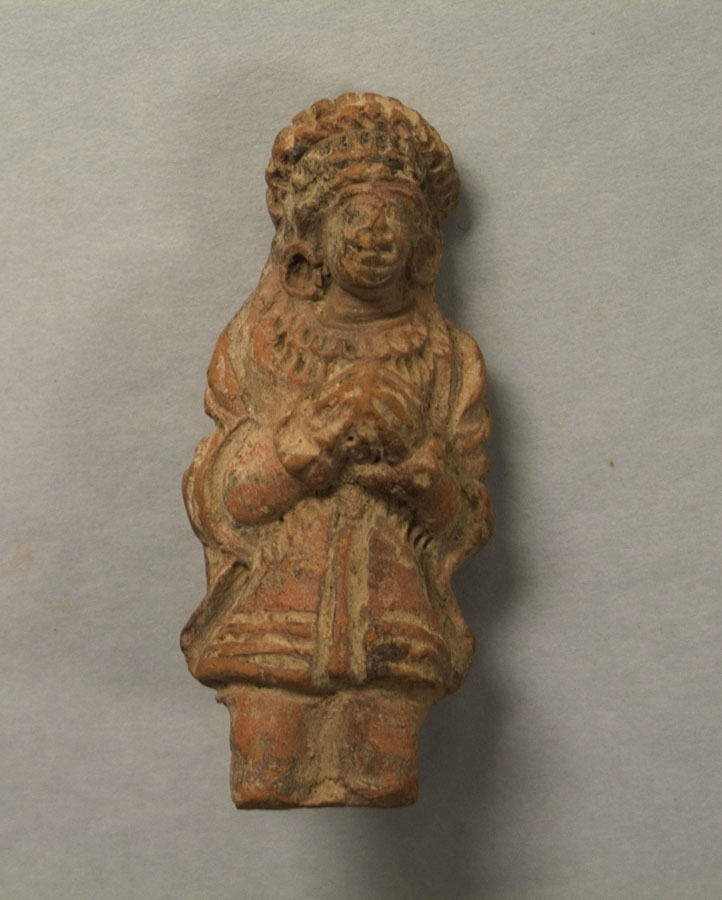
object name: shard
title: Lug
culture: pakistani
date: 301-500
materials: terracotta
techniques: painting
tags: human figures,gandhara